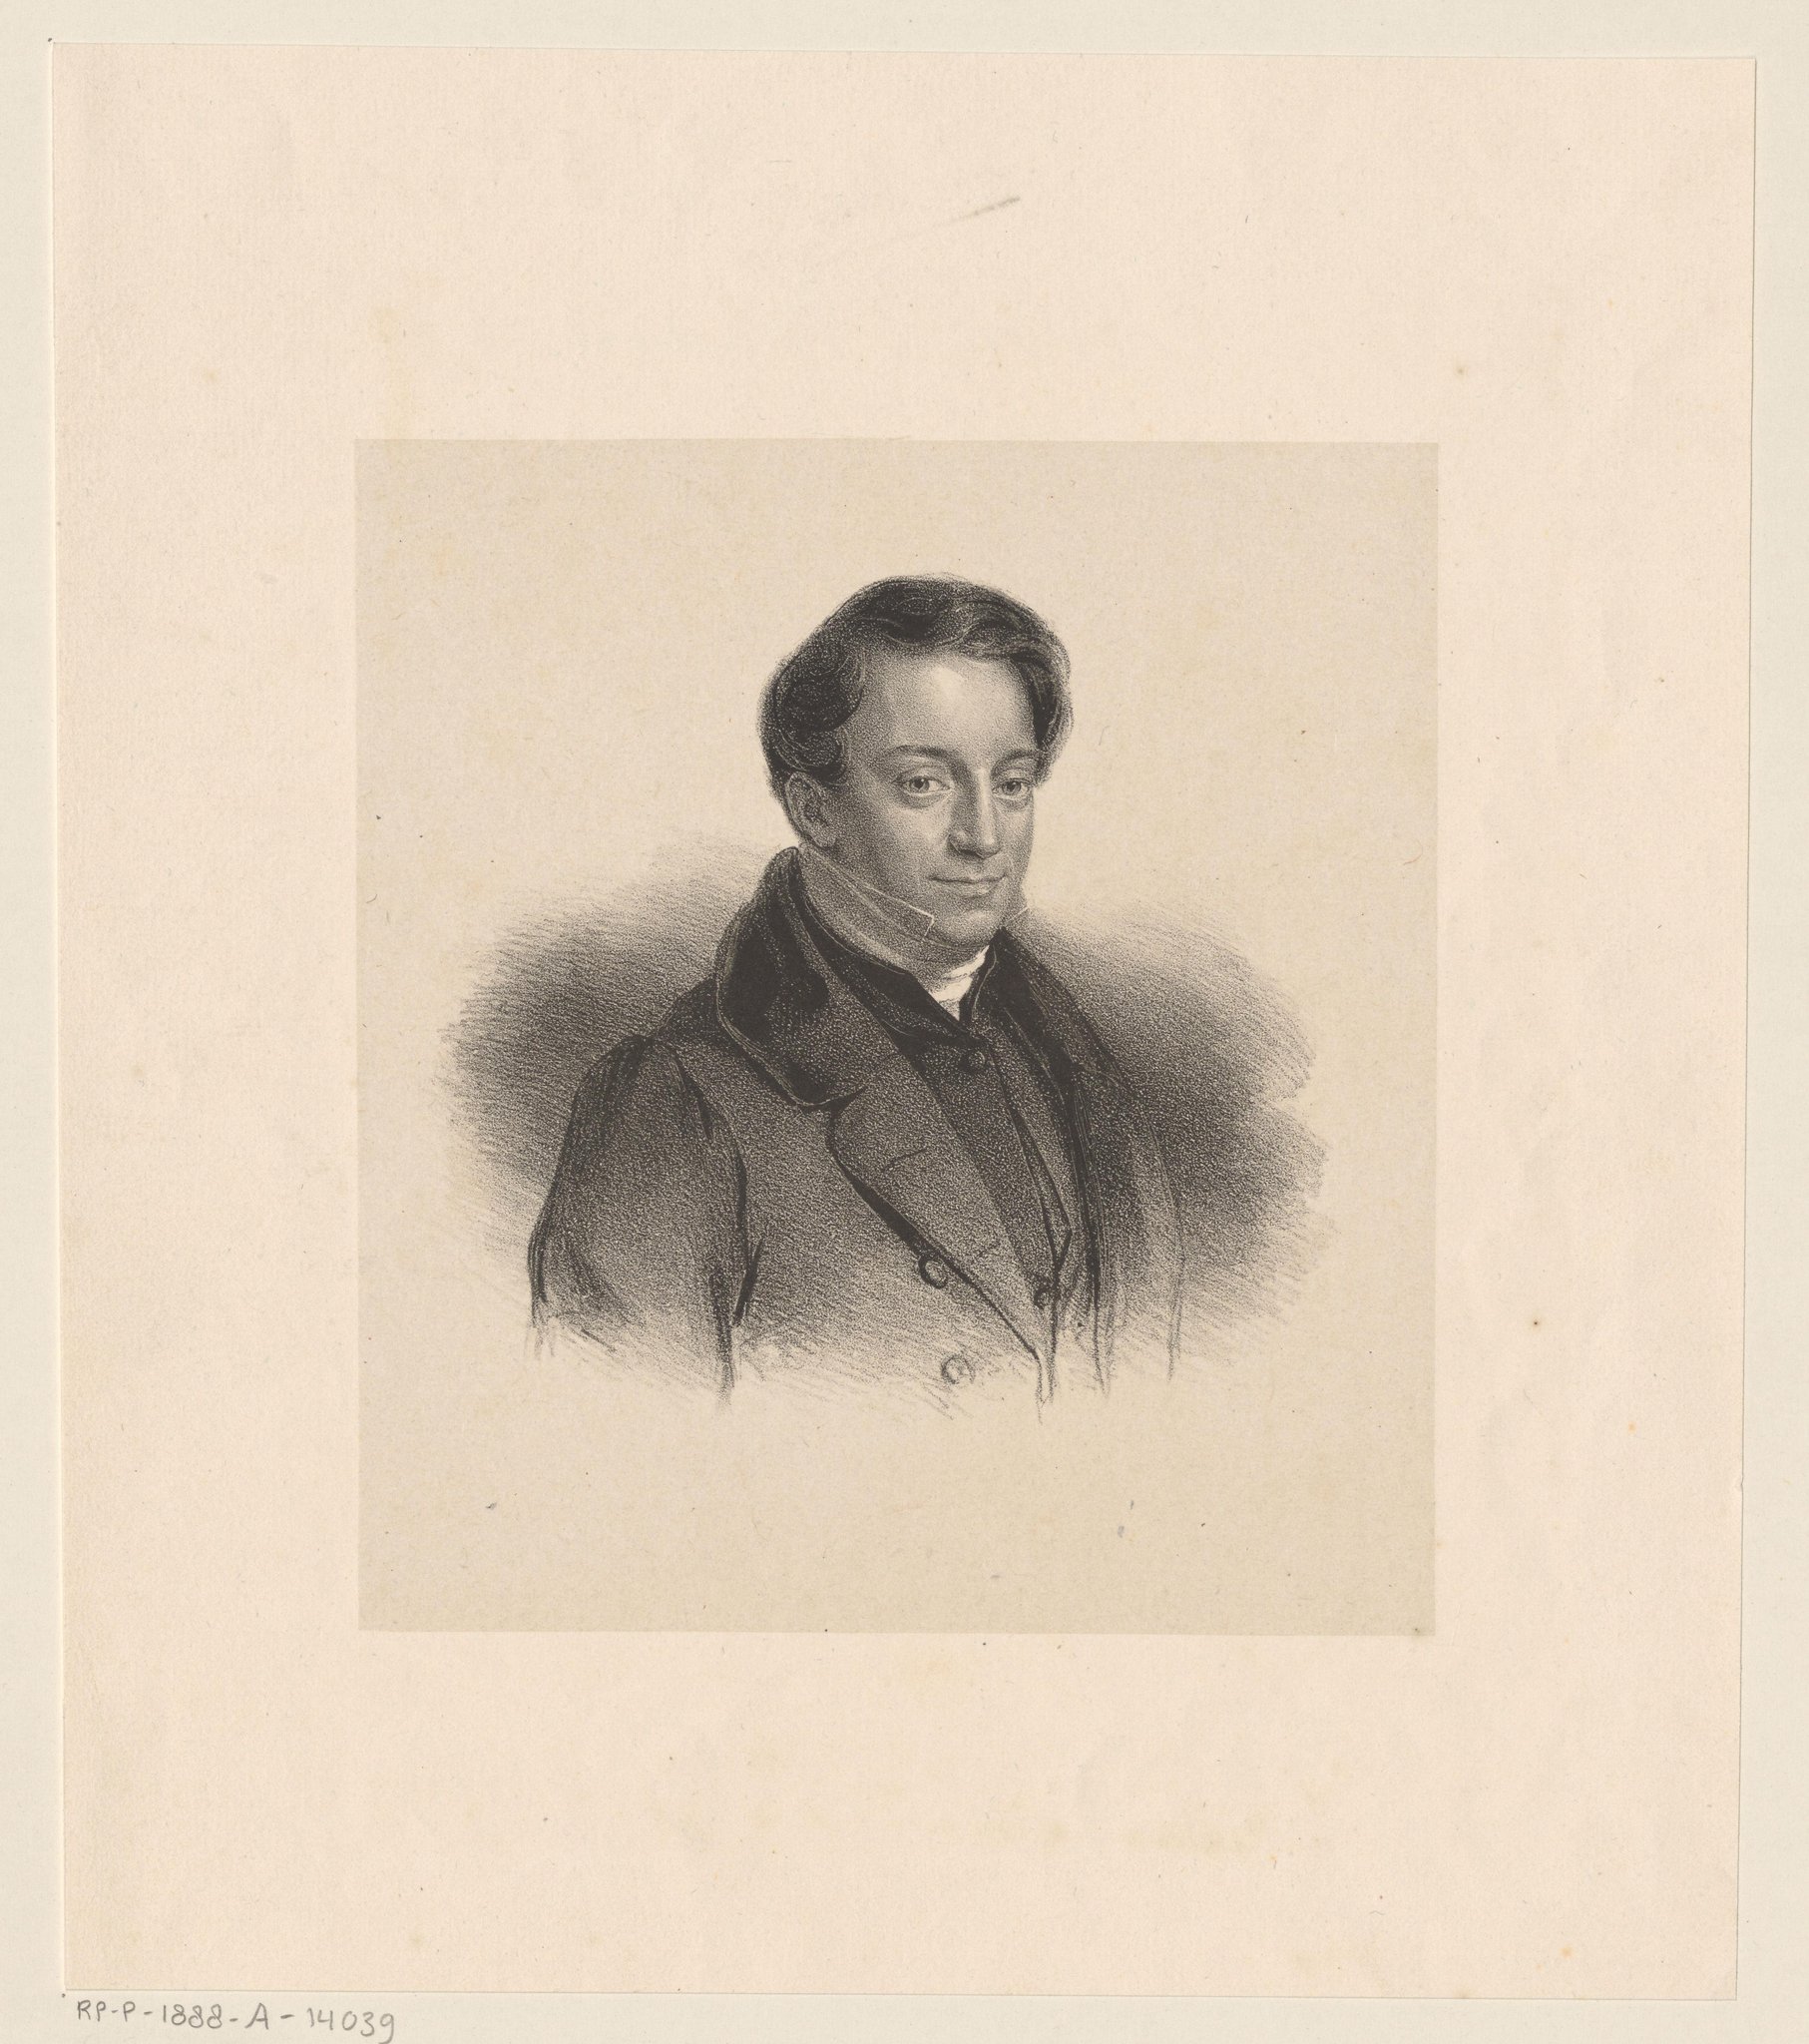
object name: print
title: Portret van Johannes Jacobus Bredius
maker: jean baptiste madou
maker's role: draughtsman, painter, print maker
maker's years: 1796-1877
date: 1806-1877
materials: paper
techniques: lithograph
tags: historical persons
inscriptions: collector's mark: Lugt 2228, collector's mark: Lugt 698